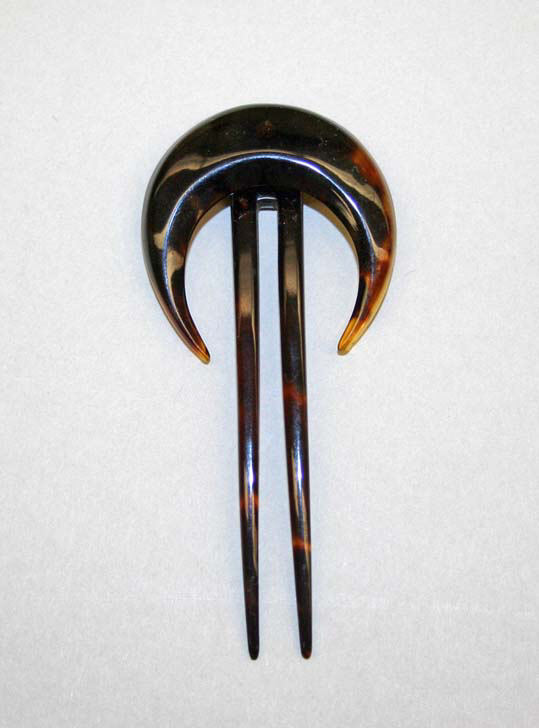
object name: hairpin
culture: american or european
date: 1893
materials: shell